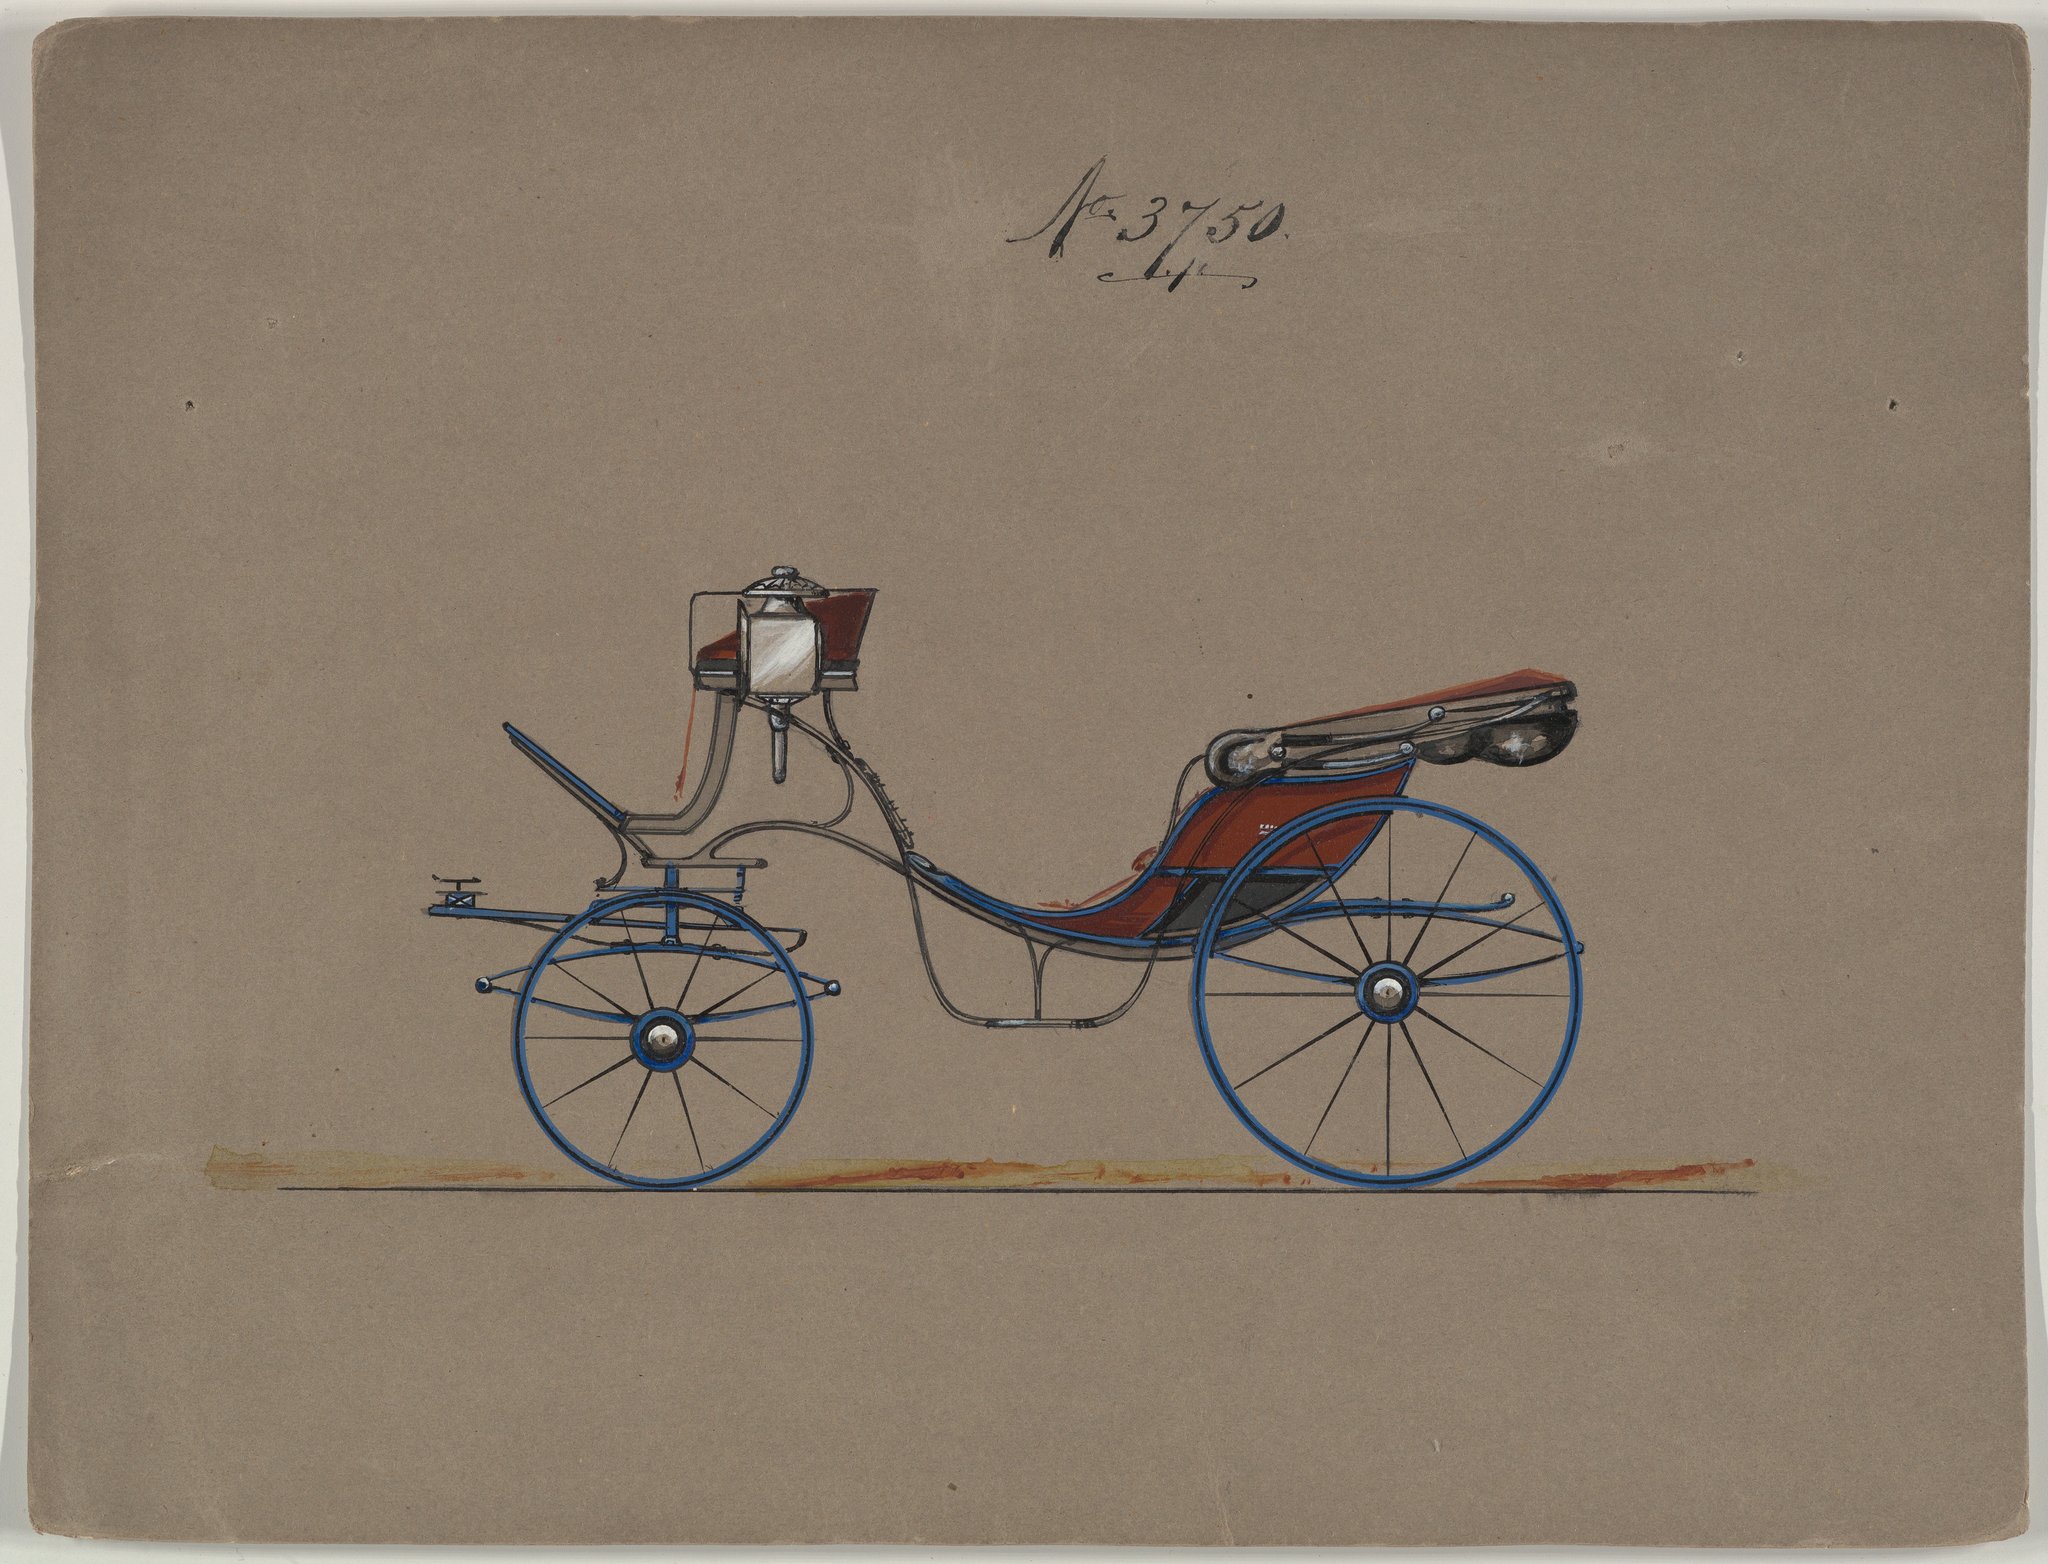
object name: drawing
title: Design for Cabriolet or Victoria, no. 3750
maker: brewster & co.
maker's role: manufacturer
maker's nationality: american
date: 1882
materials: gouache, gum arabic, ink, watercolor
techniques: pen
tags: carriages